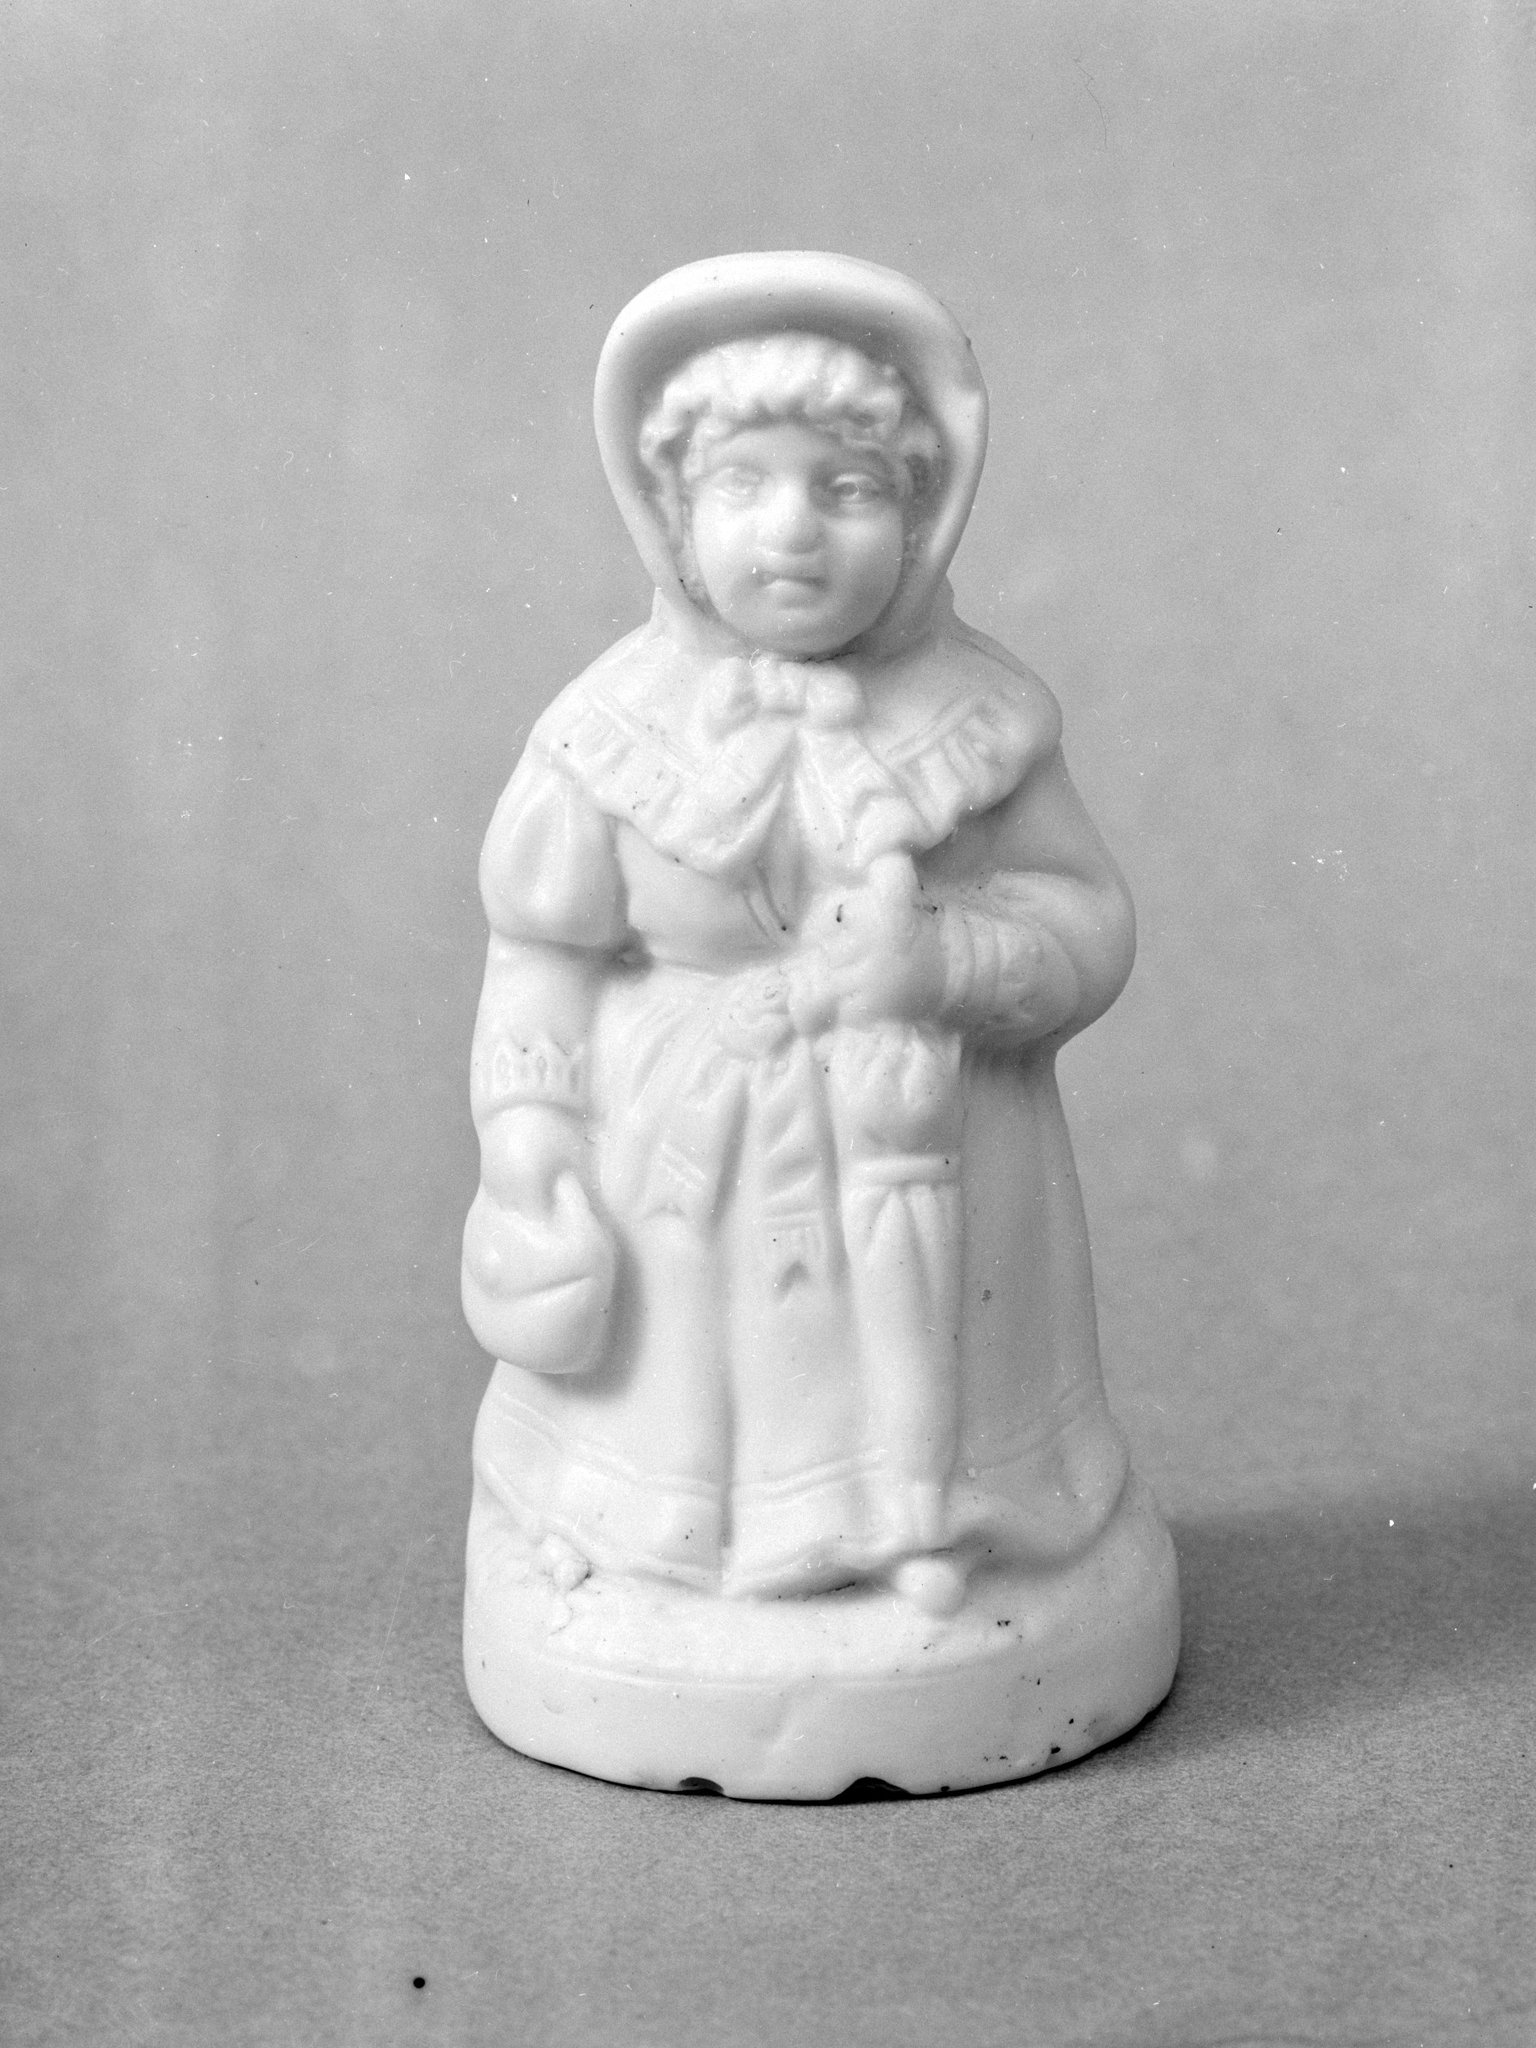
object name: figure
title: Female Figure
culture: american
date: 1830-1870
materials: porcelain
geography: united states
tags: women